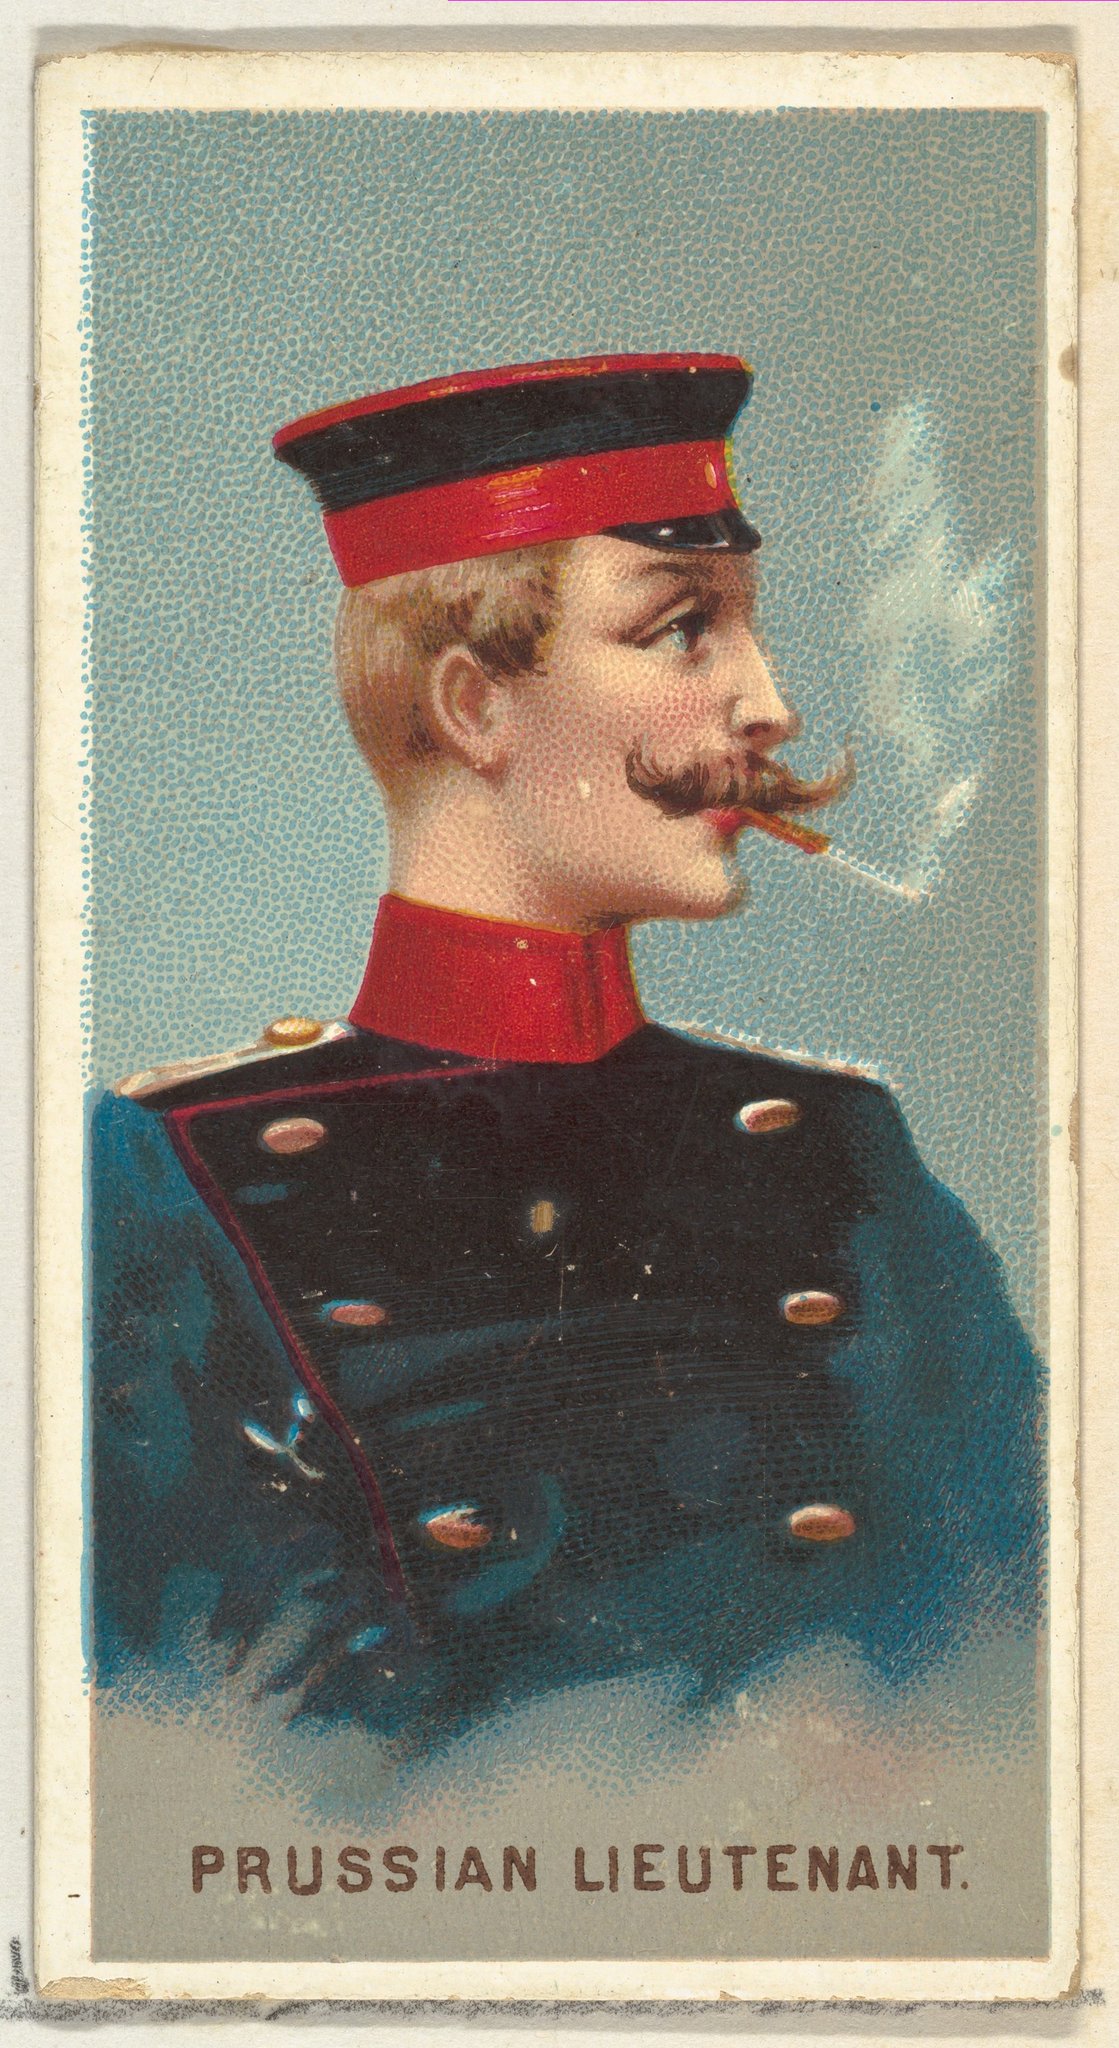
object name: print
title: Prussian Lieutenant, from World's Smokers series (N33) for Allen & Ginter Cigarettes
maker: allen & ginter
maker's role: publisher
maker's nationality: american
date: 1888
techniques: color lithograph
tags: men,profiles,smoking